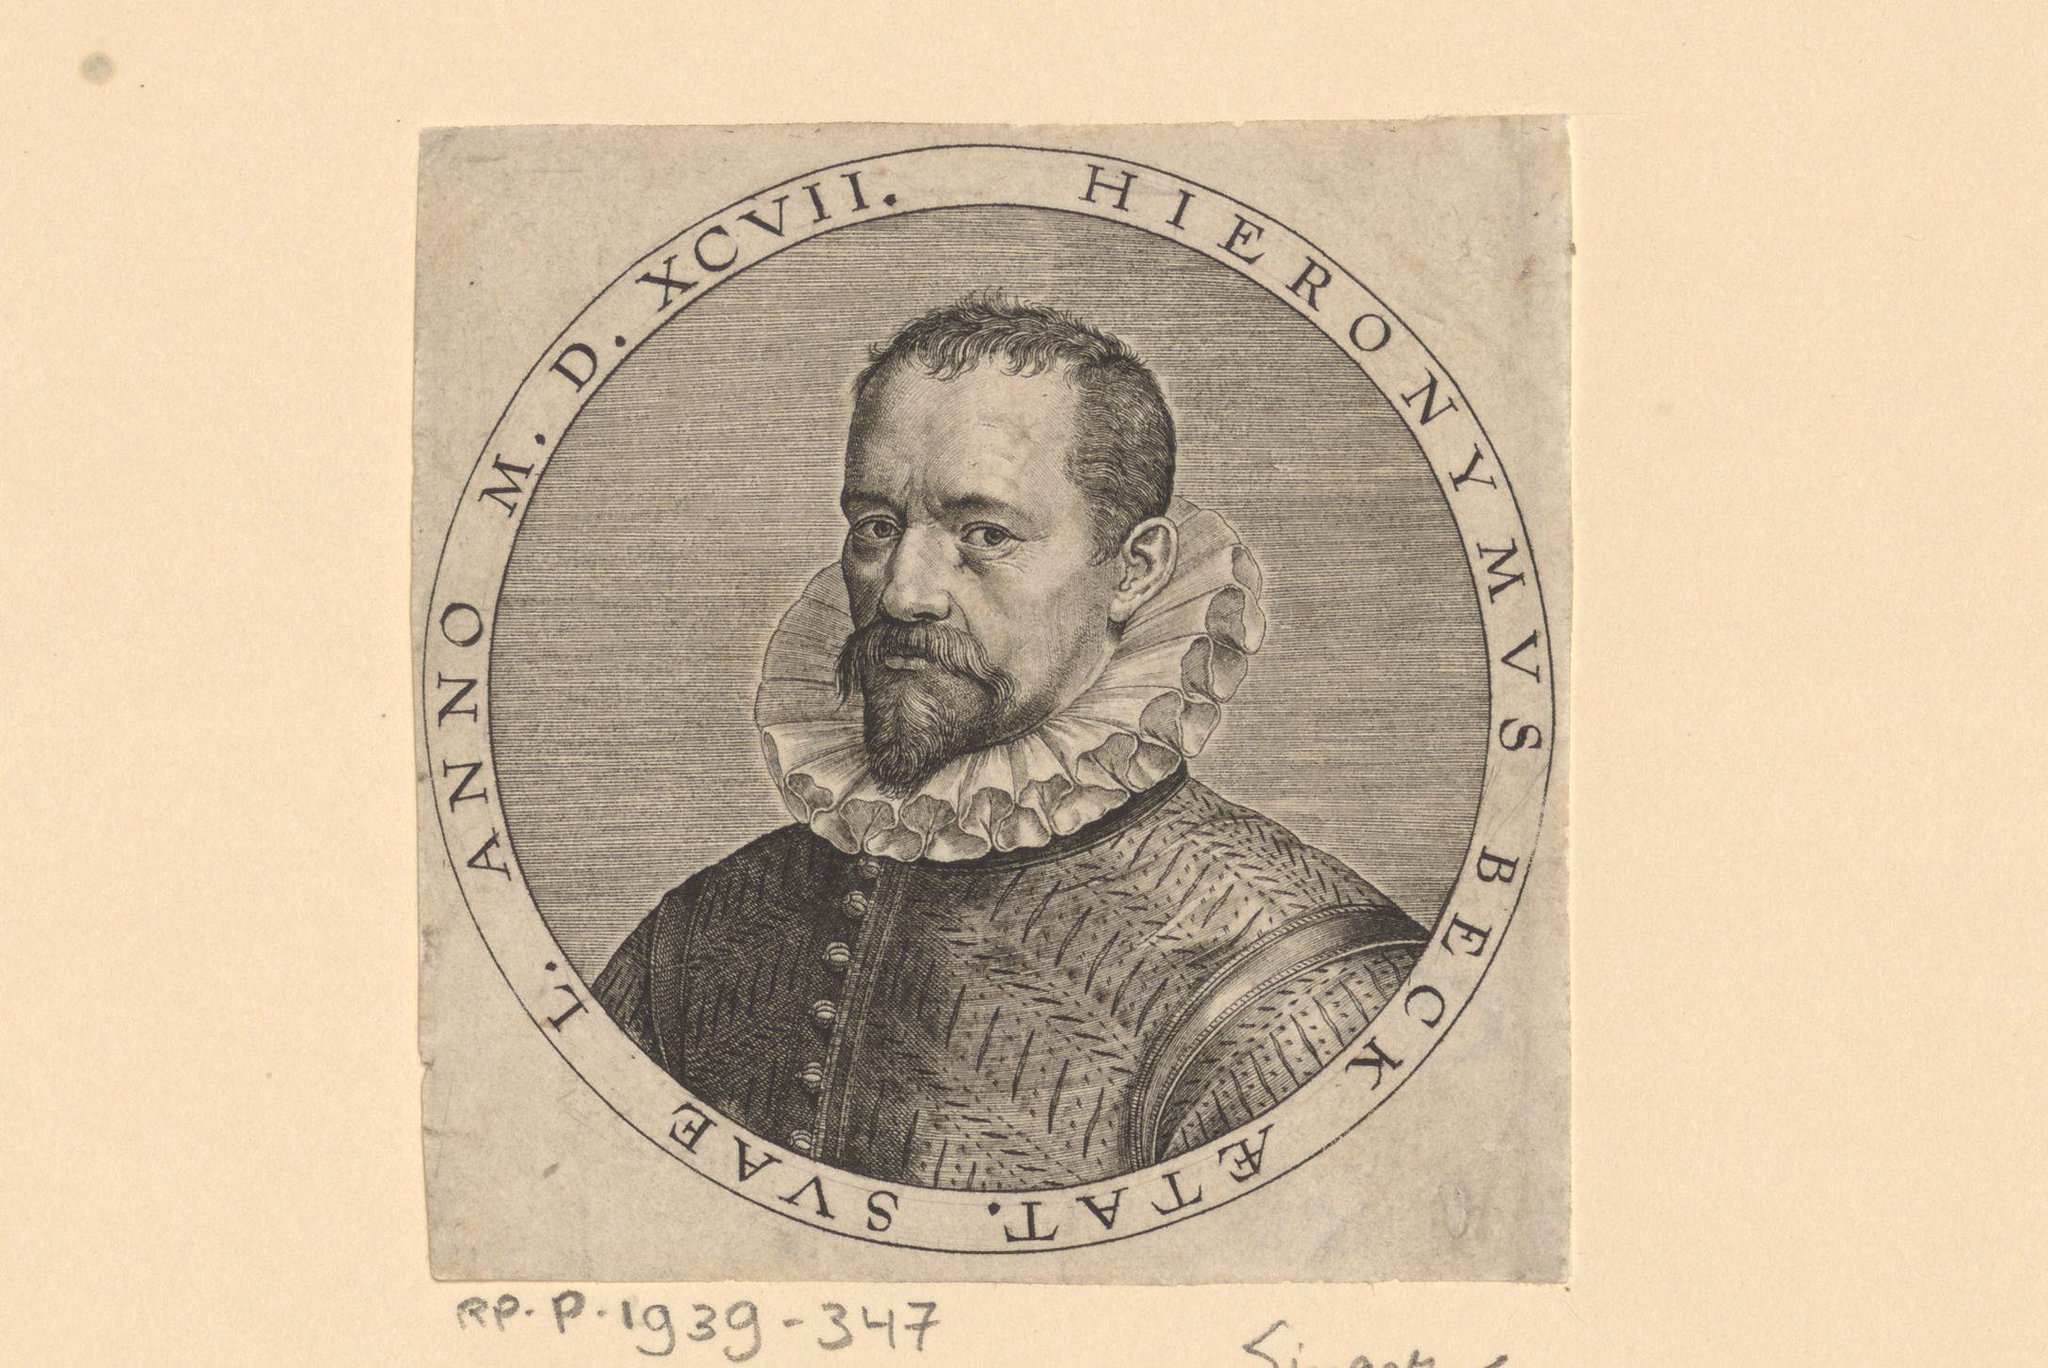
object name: print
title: Portret van Hieronymus Beck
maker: johannes wierix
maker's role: draughtsman, print maker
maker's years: 1549-1618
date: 1597-1618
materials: paper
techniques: engraving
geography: antwerp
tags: historical persons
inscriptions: collector's mark: Lugt 2760, collector's mark: Lugt 2228